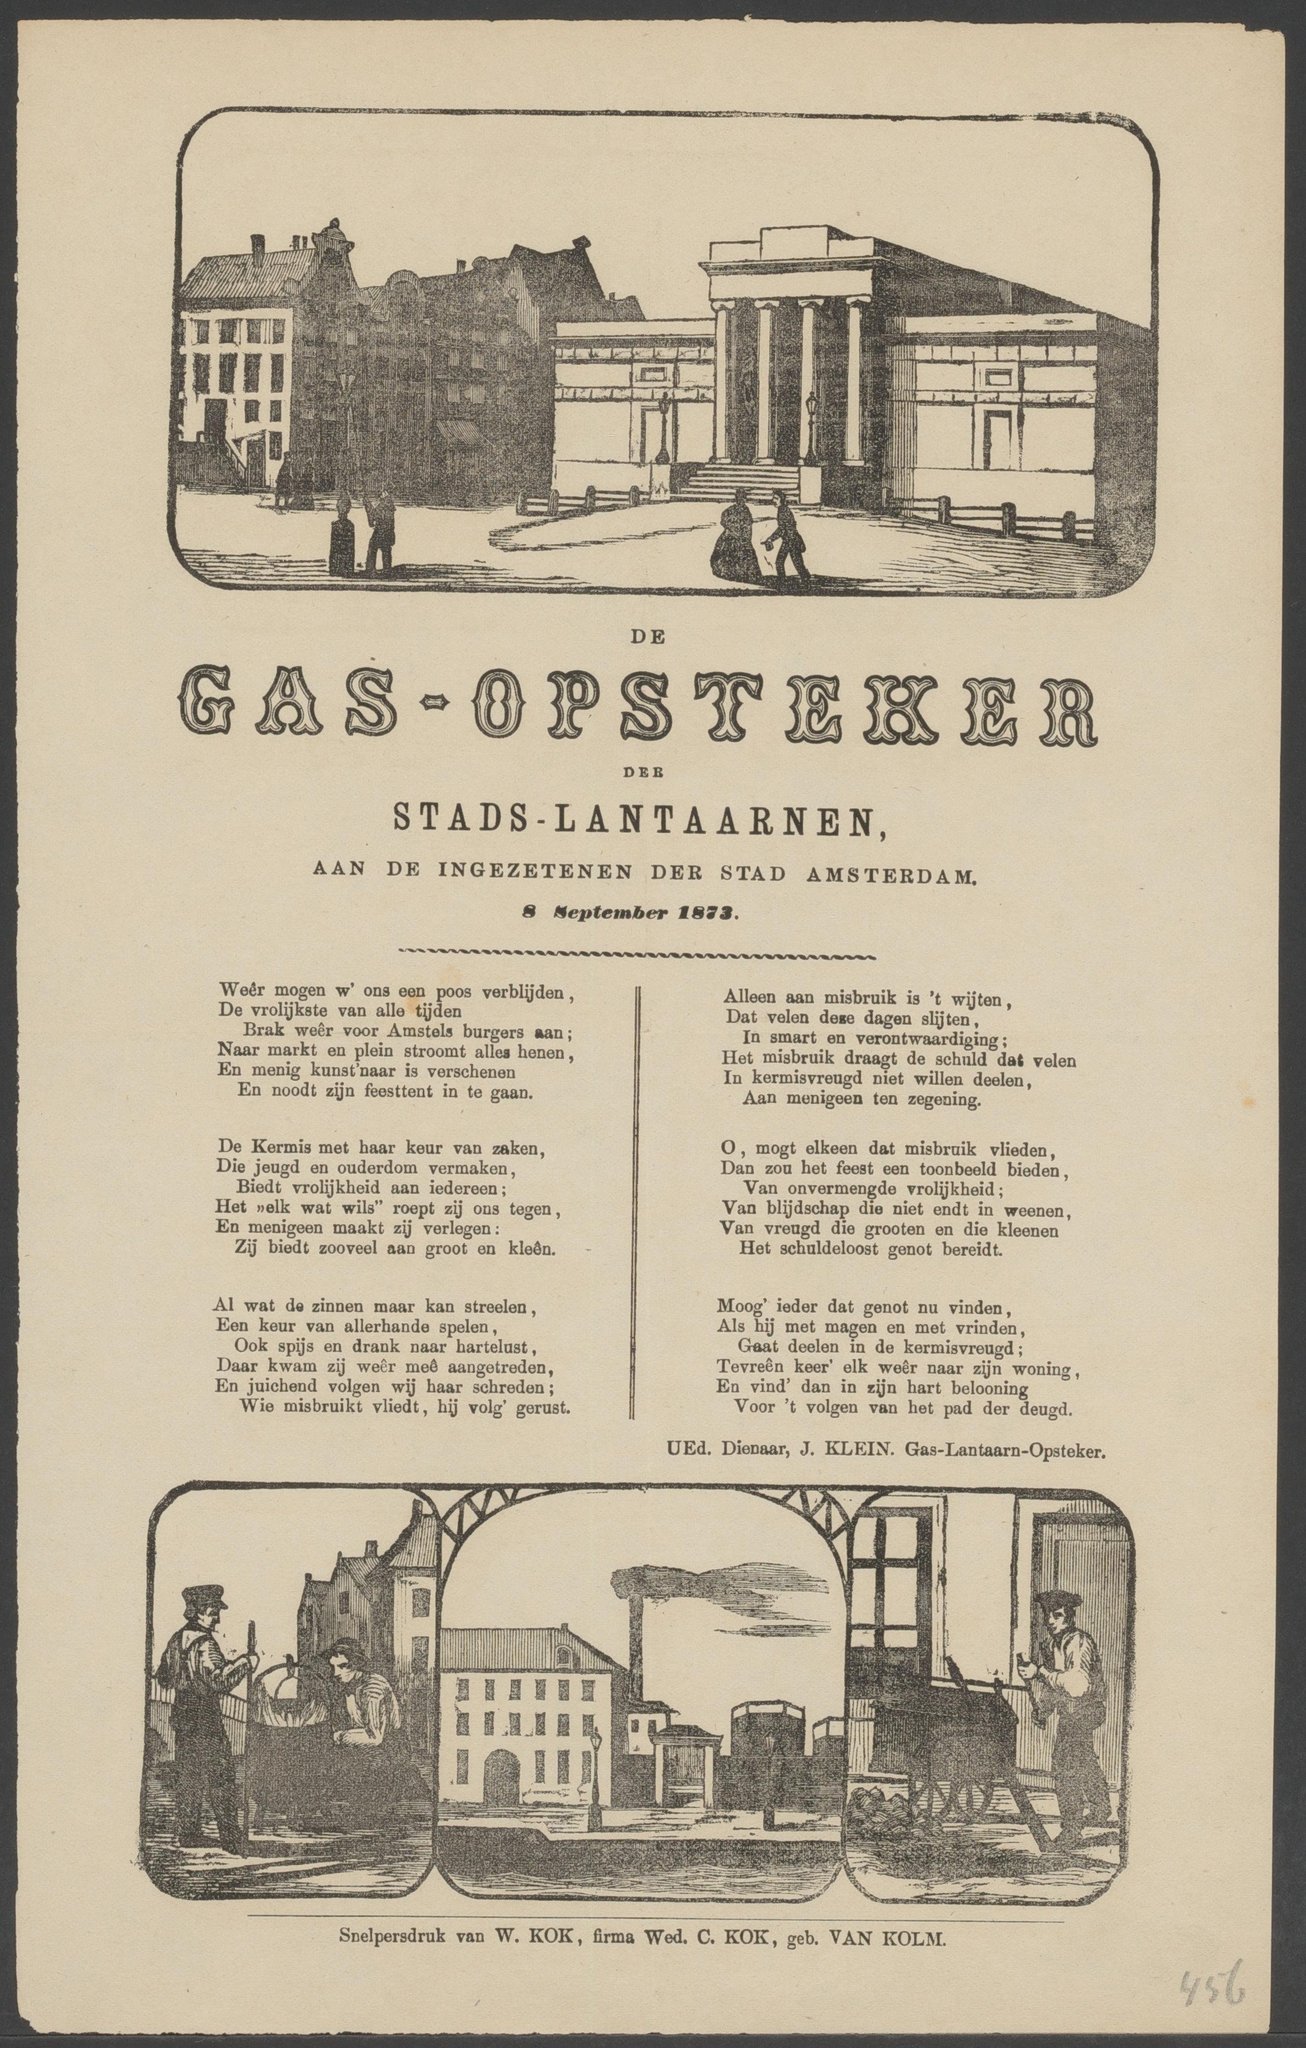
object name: print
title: De Gas-opsteker der Stads-lantaarnen, aan de ingezetenen der stad Amsterdam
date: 1873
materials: paper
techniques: letterpress printing, engraving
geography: amsterdam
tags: gas-lamp, gas supply, digging (industrial process), street lighting, amsterdam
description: Kermiswens van de Amsterdamse gaslantaarnopstekers voor het jaar 1873. Centraal een vers in twee kolommen. Bovenaan de Dam met de beurs van Zocher te Amsterdam. Onderaan de Hollandsche Gasfabriek en twee gasfitters aan het werk. Van de gaslantaarnopsteker: J. Klein. Onderwerpsrubrieken binnen de Atlas Zeden en Gewoonten: Zeden en gewoonten in engeren zin, Volksleven, Volksbladen, Nieuwjaars- en Kerstwenschen, Amsterdam.